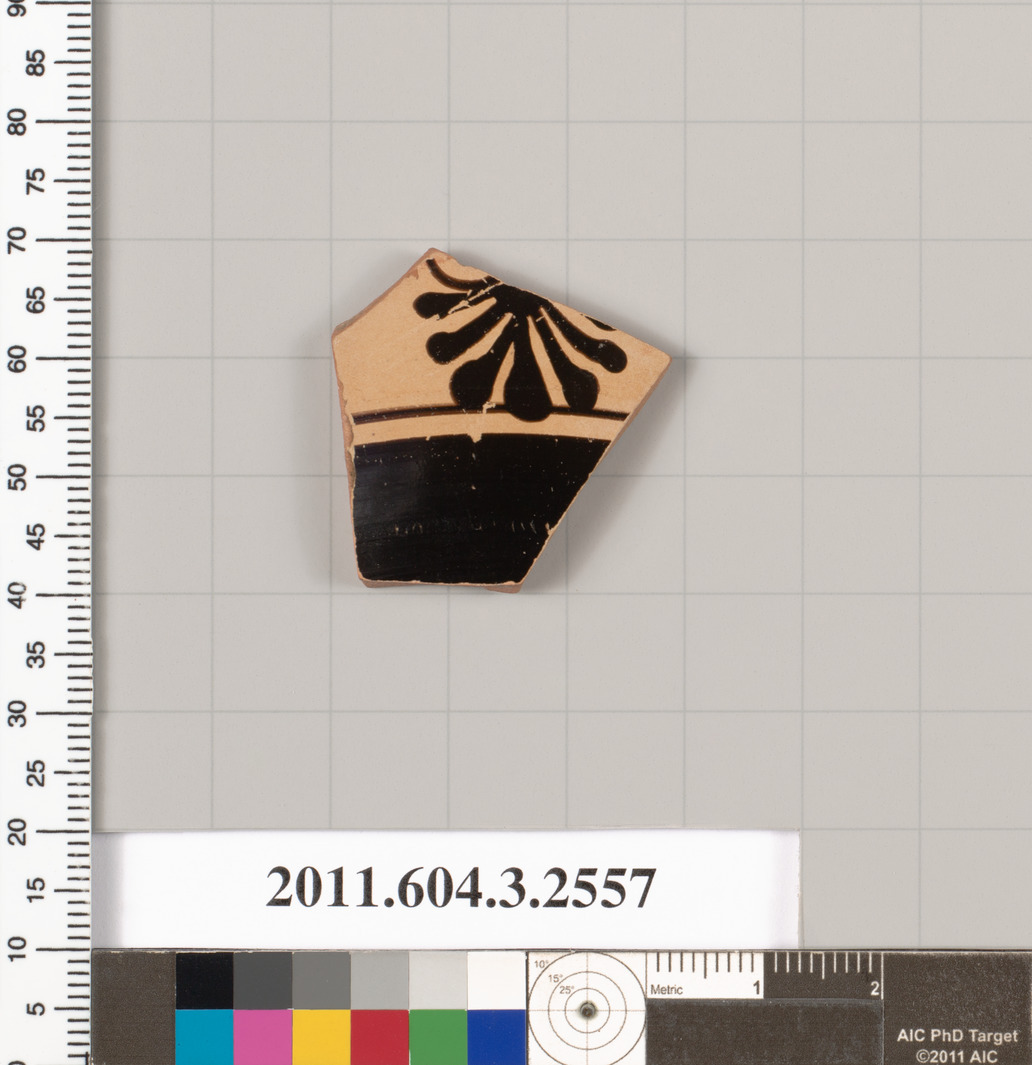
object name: kylix fragment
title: Terracotta fragment of a kylix (drinking cup)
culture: greek, attic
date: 534-468 BCE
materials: terracotta